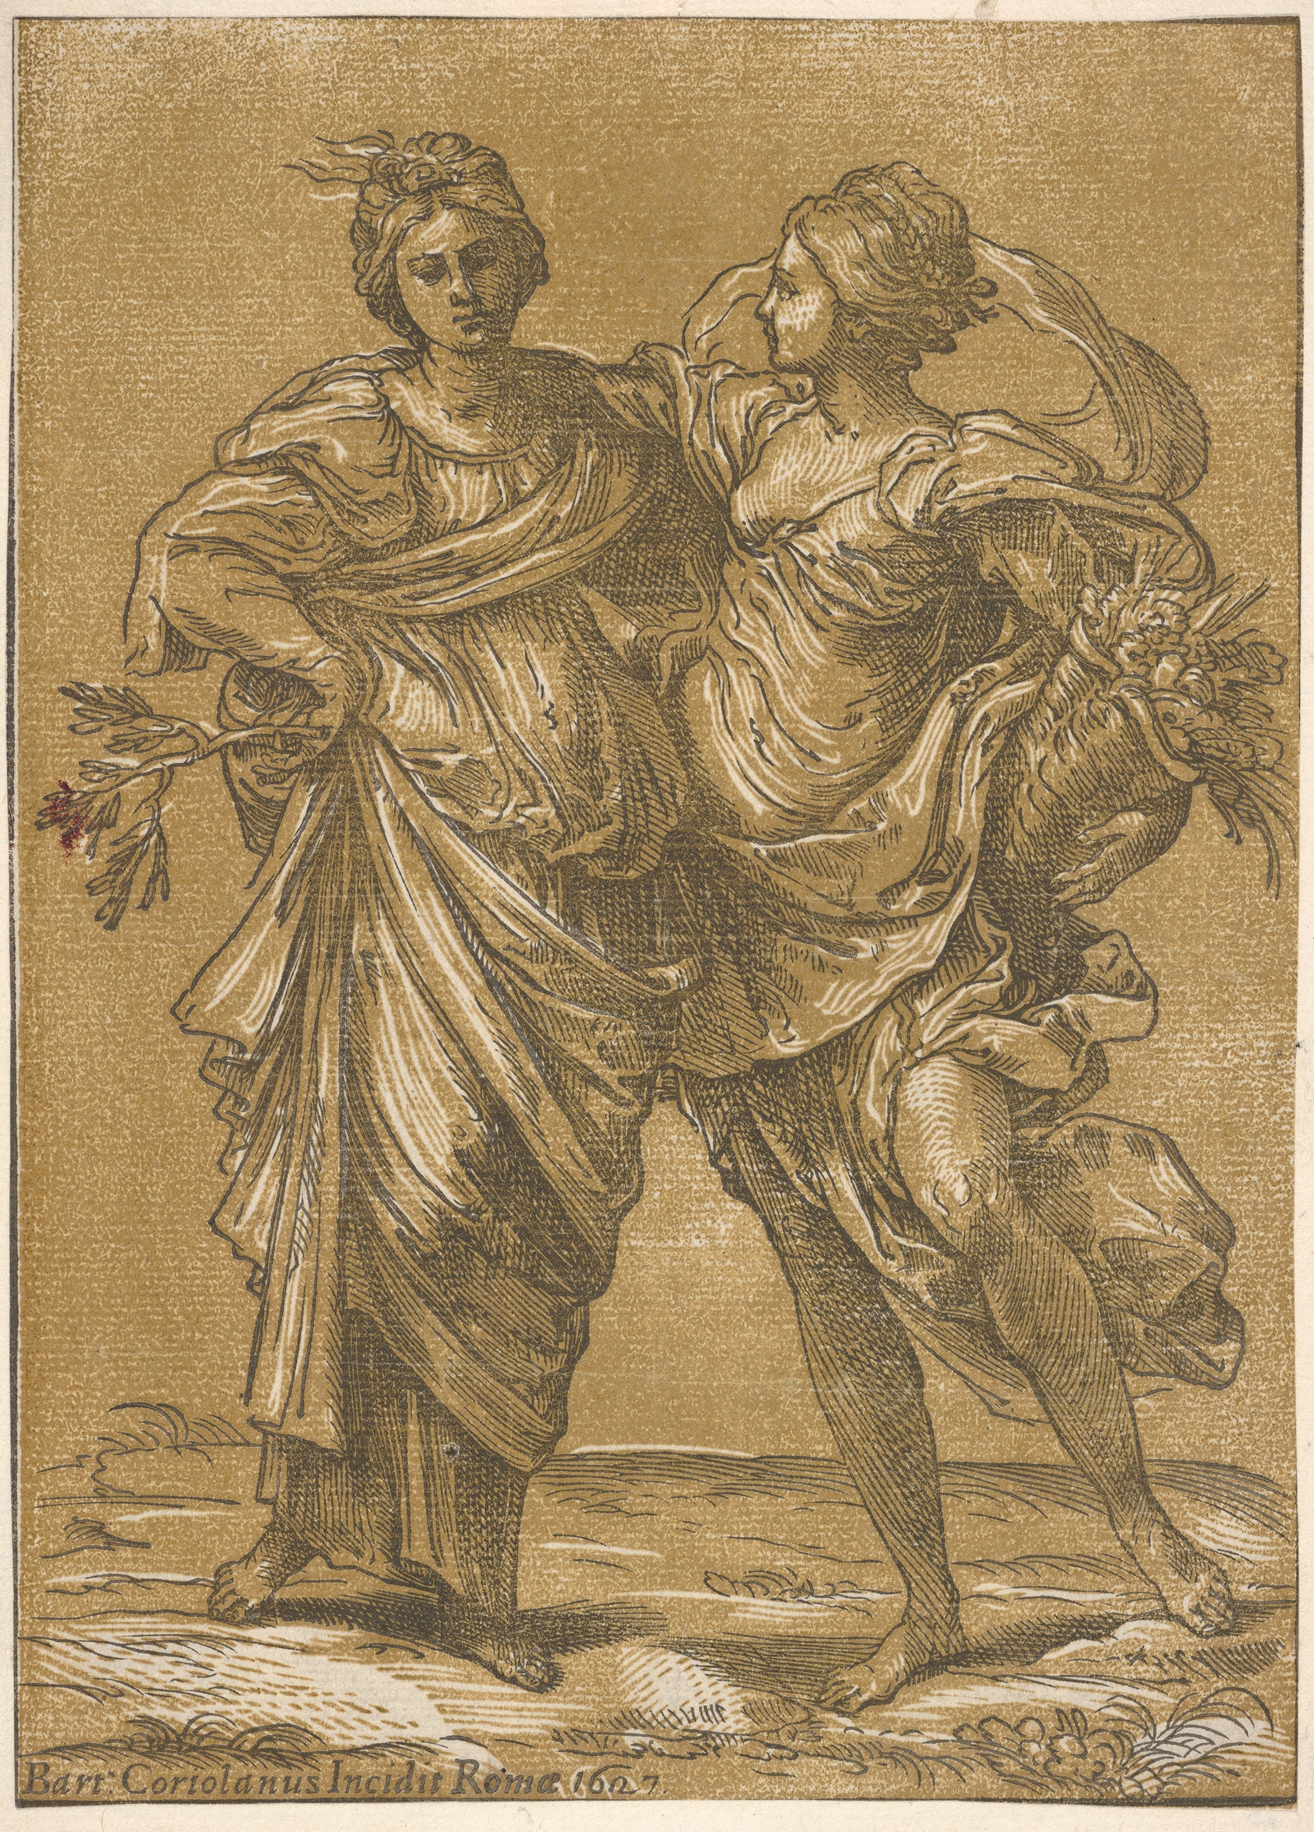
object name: print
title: Two women representing the alliance of Peace and Abundance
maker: bartolomeo coriolano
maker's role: artist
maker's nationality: italian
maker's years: 1599-1676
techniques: woodcut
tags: women,cornucopia